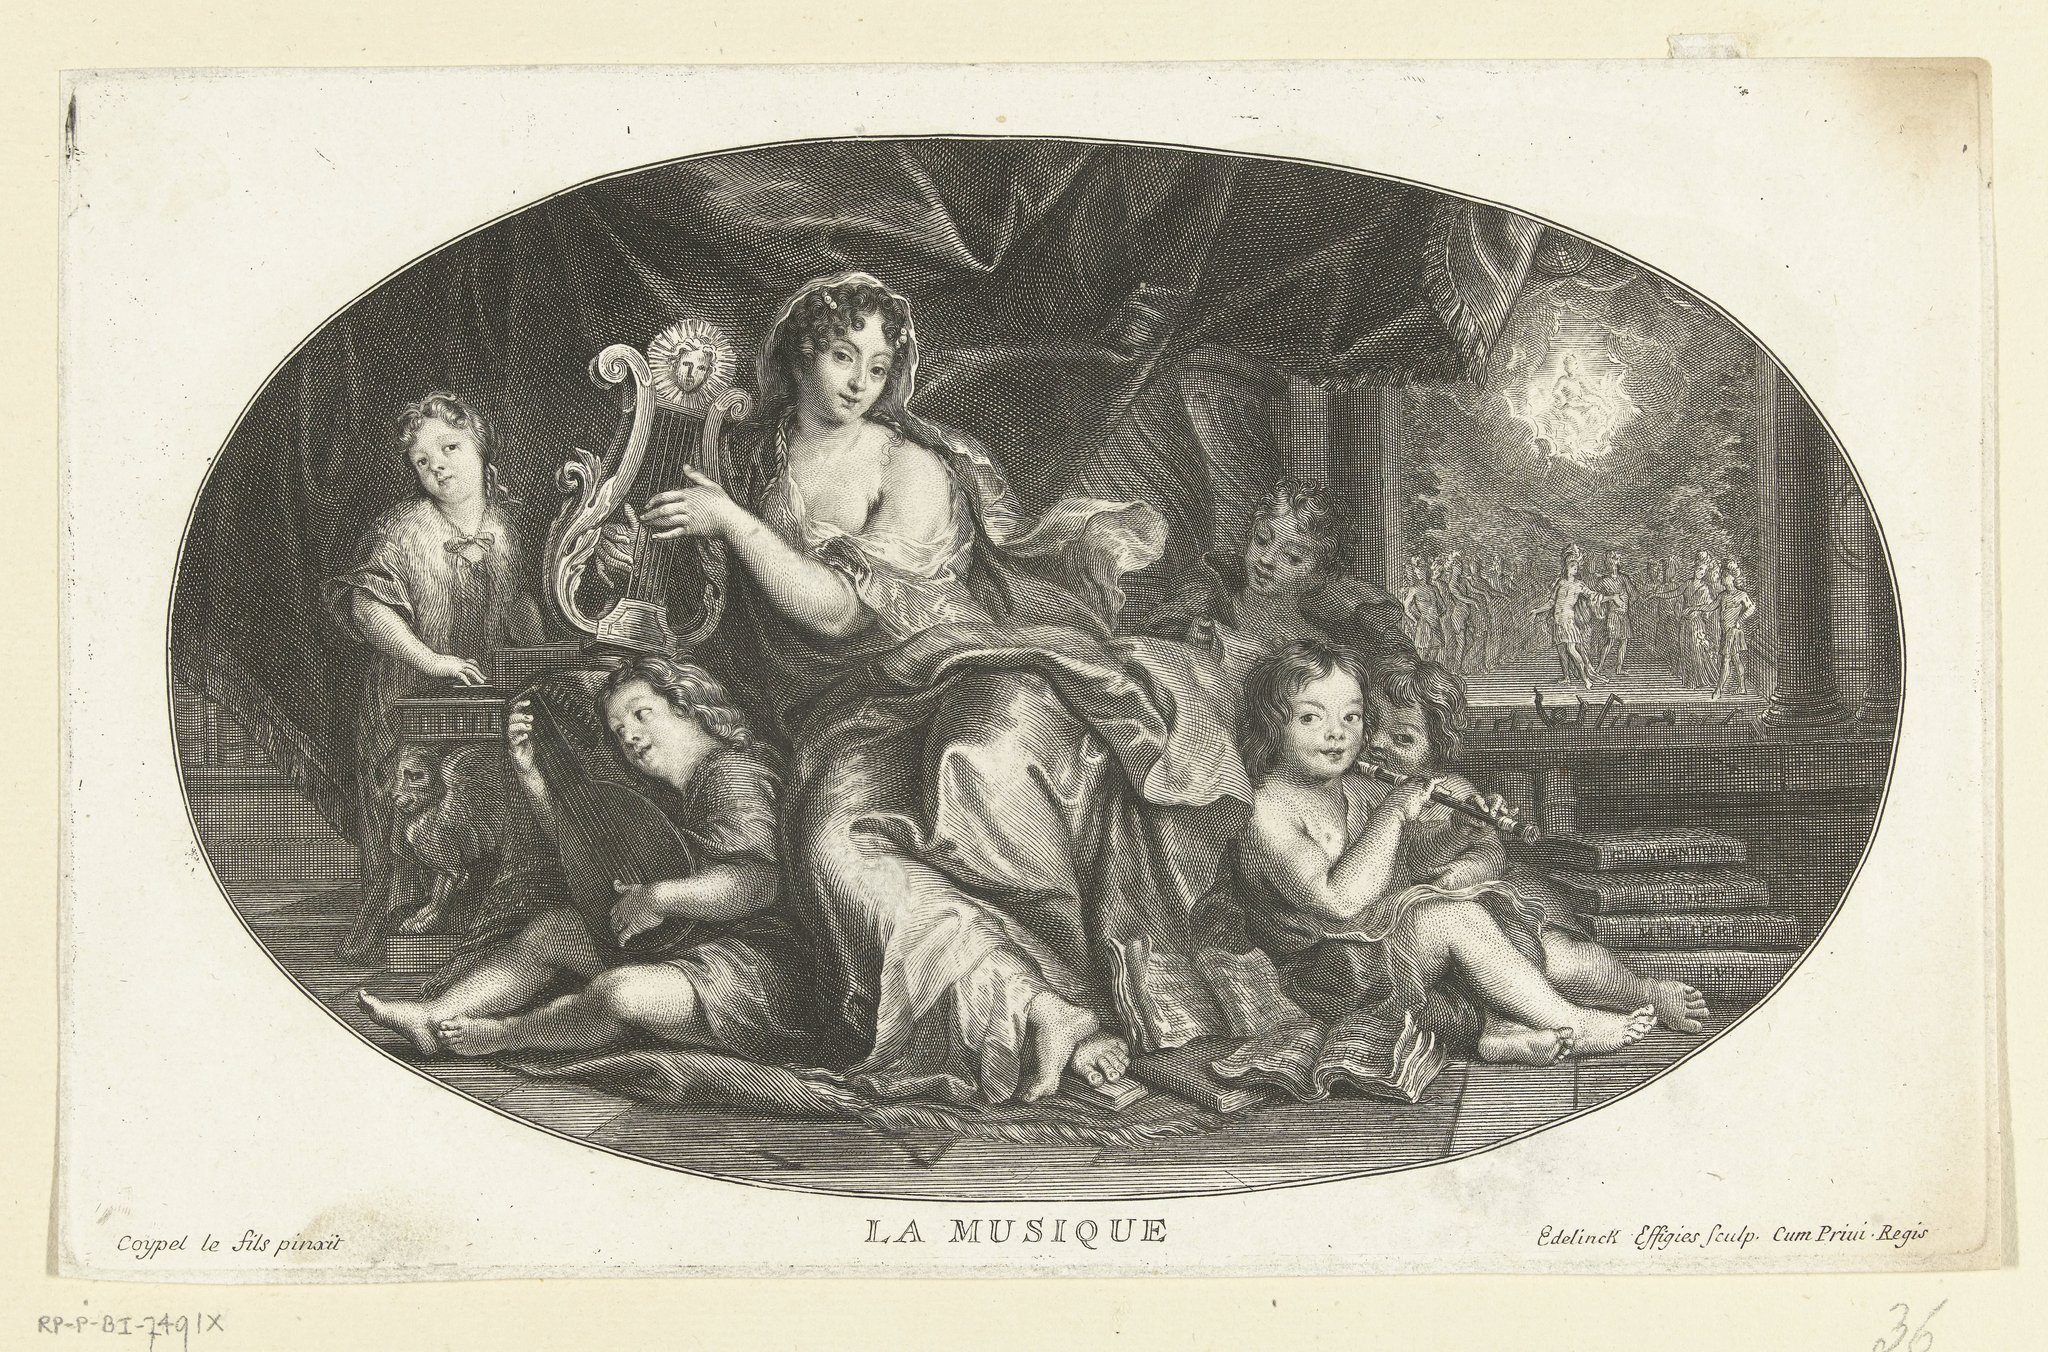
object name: print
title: Allegorie op de Muziek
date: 1666-1707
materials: paper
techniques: engraving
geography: paris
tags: 'musica', symbolic representations, allegories and emblems ~ music; 'musica'(ripa), euterpe (one of the muses); 'euterpe' (ripa)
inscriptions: collector's mark: Lugt 240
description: Vrouwelijke personificatie van de Muziek, Euterpe, bespeelt de harp terwijl ze is omringd door musicerende kinderen. Op de achtergrond een gezicht op het toneel van de Parijse Opéra.